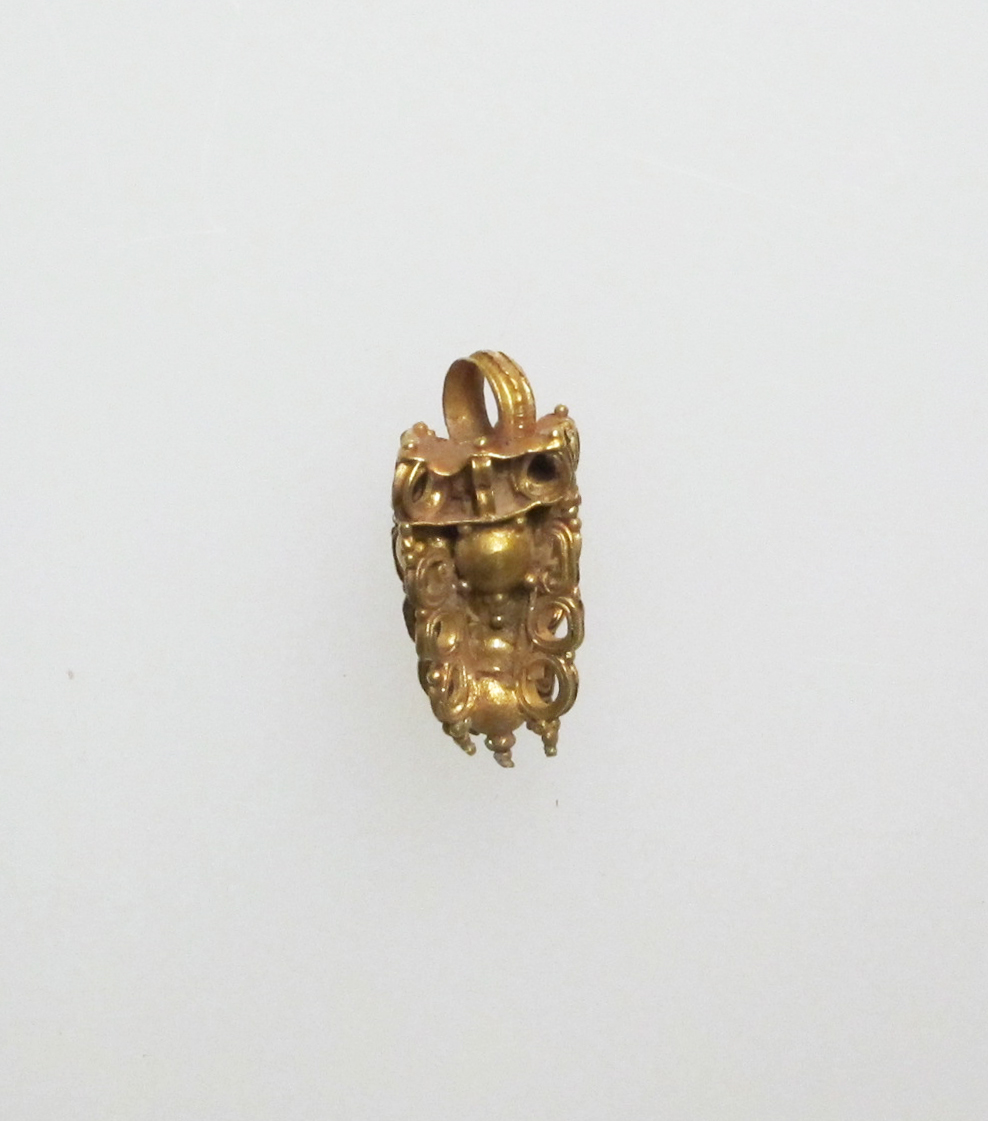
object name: pendant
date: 7000 BCE-330 CE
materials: gold